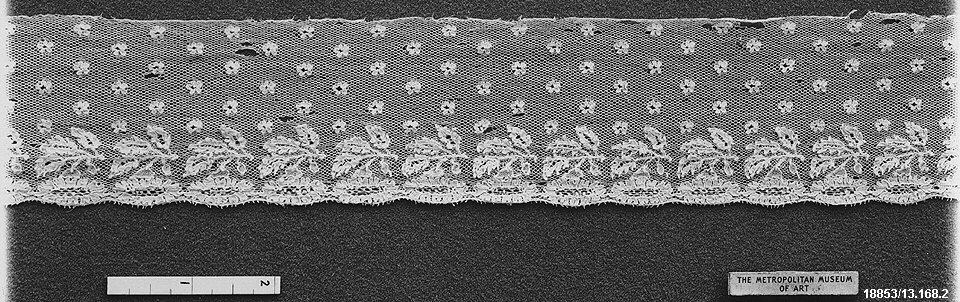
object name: border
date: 1767-1800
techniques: lace